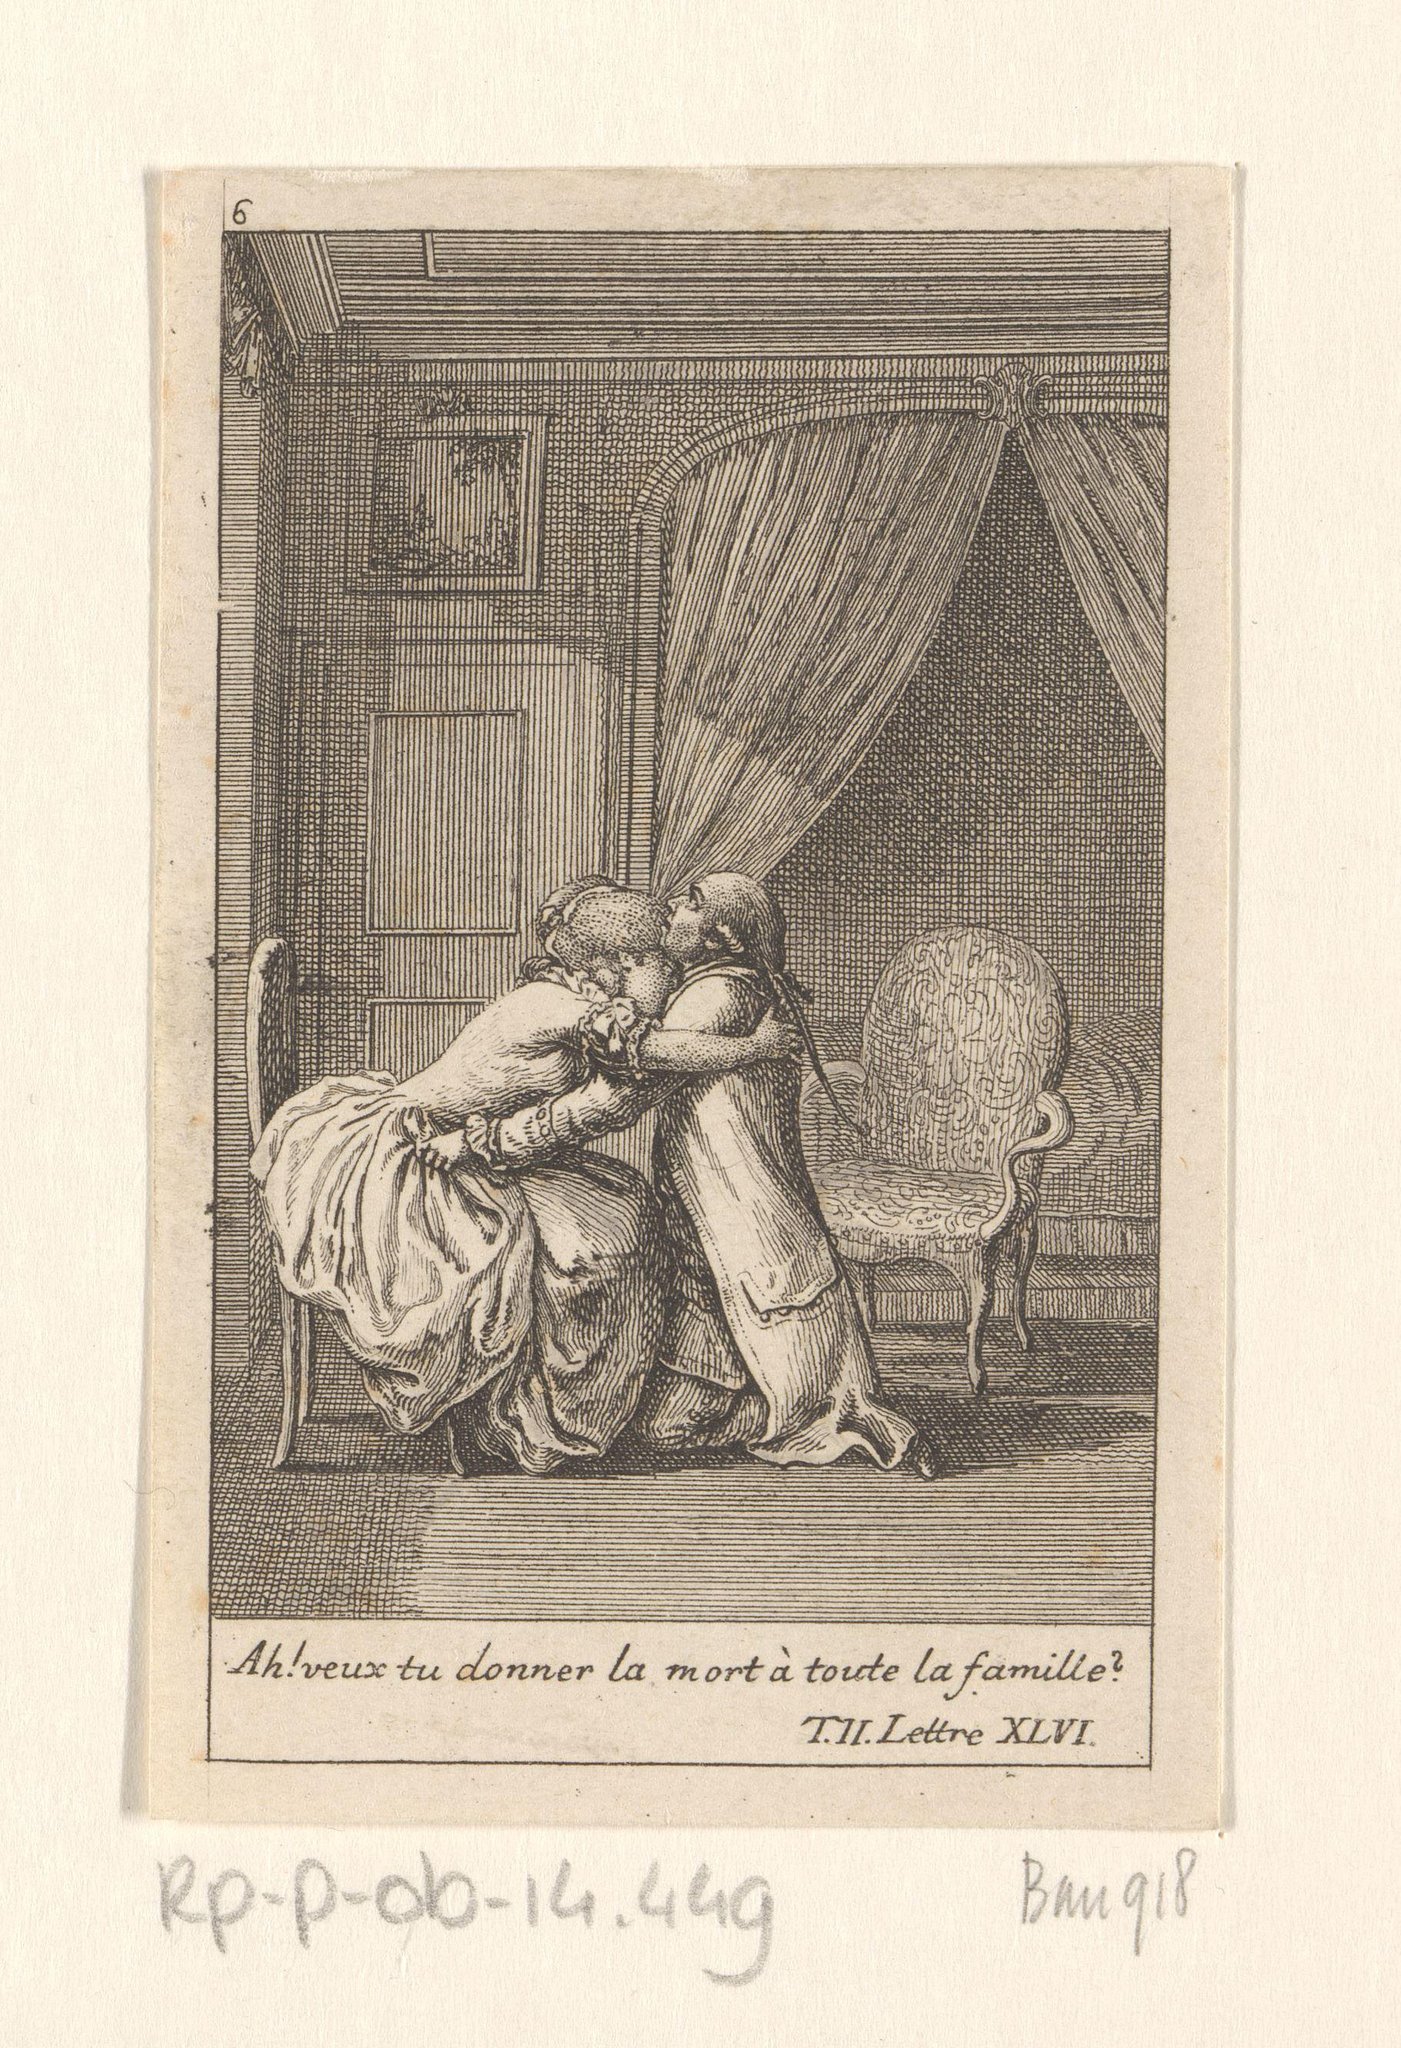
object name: book illustration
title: Julies vader smeekt haar te scheiden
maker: daniel nikolaus chodowiecki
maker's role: draughtsman, print maker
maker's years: 1726-1801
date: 1782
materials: paper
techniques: etching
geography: berlin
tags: embracing each other, kissing, interior of the house, kneeling figure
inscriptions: collector's mark: Lugt 2228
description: Vervaardigd voor Jean-Jacques Rousseaus 'Neue Héliose'. Latere staat gebruikt voor: Almanac généalogique pour l'année 1783. Berlijn: s.n., 1782.